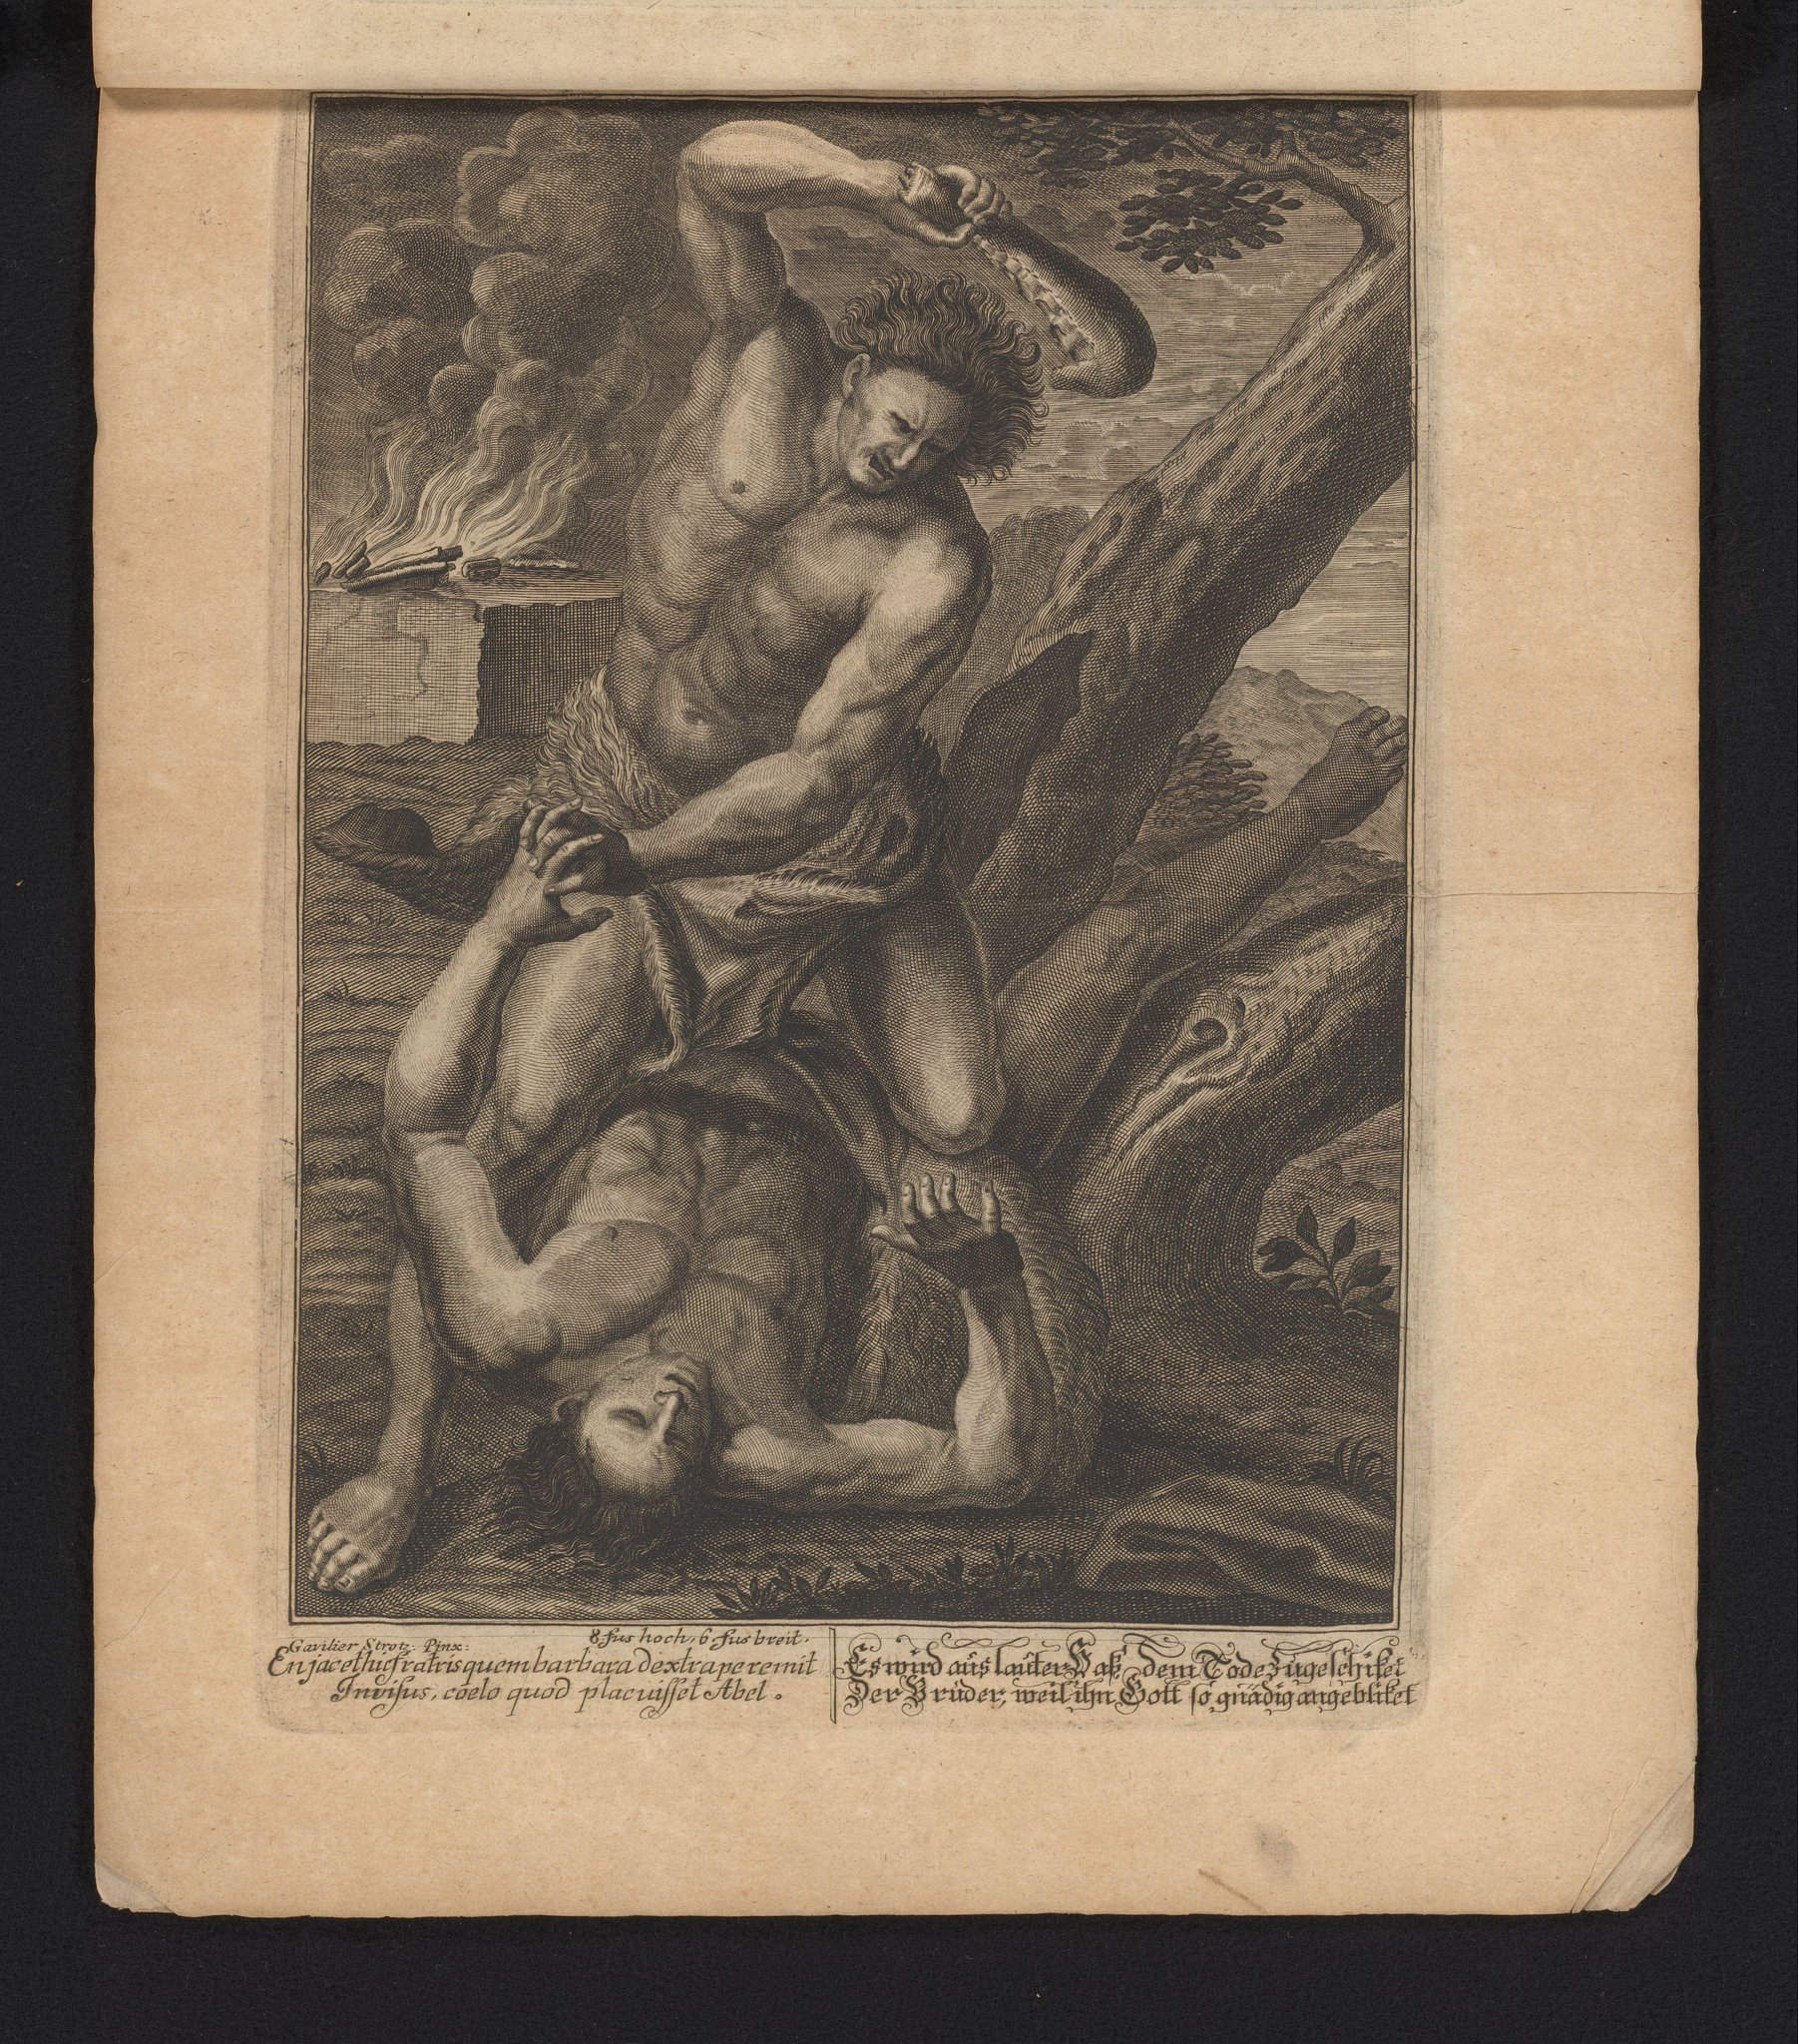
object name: album leaf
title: Kaïn doodt Abel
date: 1710-1714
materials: paper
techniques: engraving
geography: wolfenbüttel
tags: the killing of abel: cain slays him with a stone, a club or a jaw-bone, alternatively with a spade or another tool as weapon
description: Tekst in het Duits en het Latijn in de ondermarge. Prent maakt deel uit van een album.